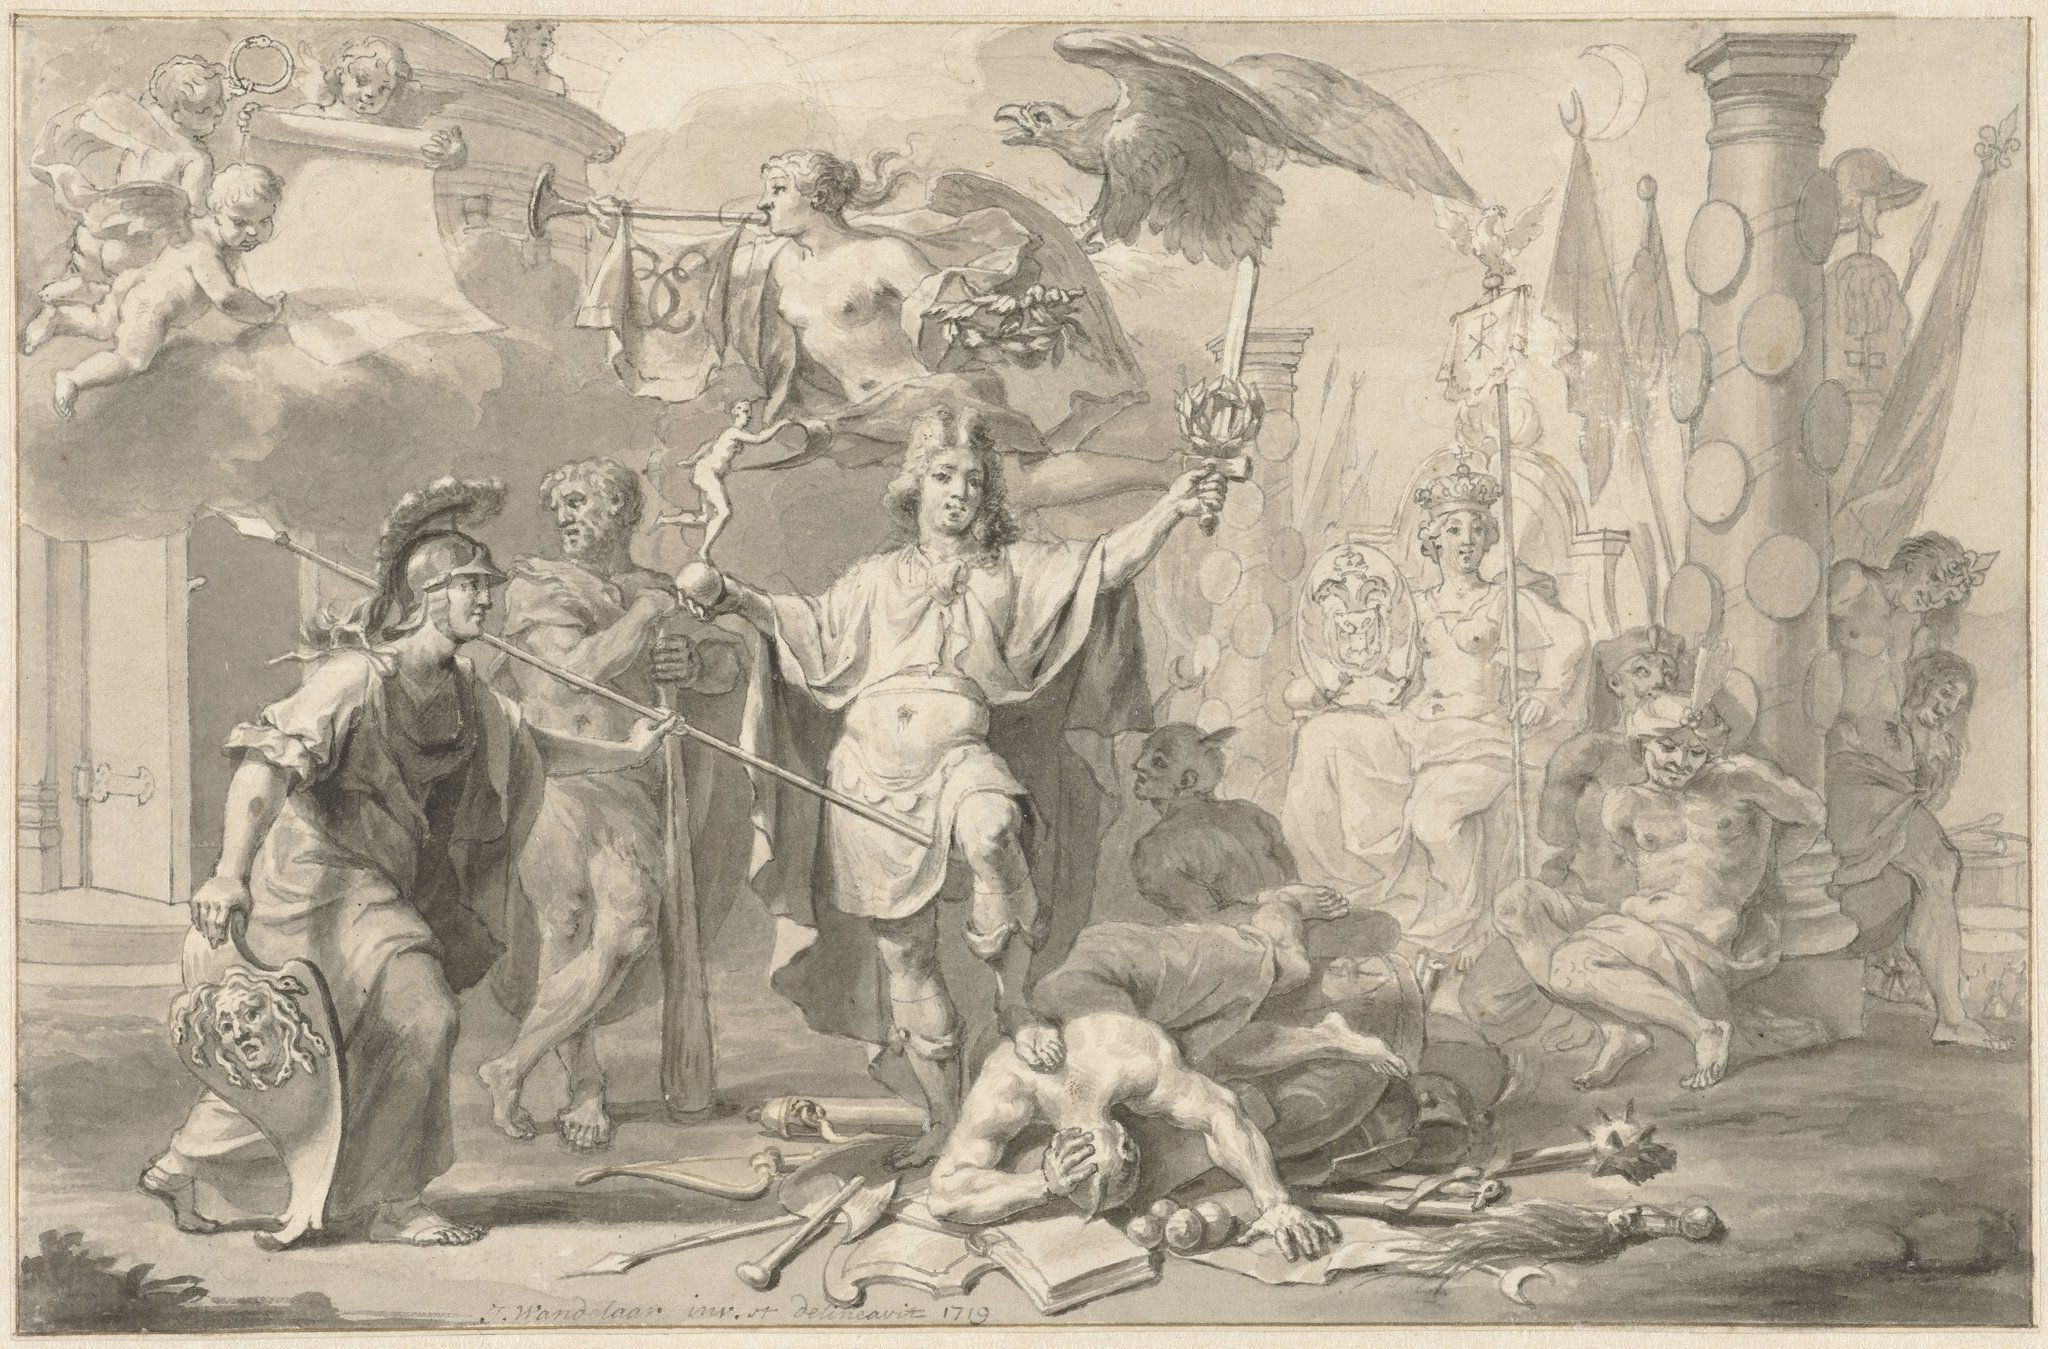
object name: design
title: Allegorie op de overwinningen van prins Eugenius van Savoye, 1719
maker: jan wandelaar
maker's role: draughtsman, print maker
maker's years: 1690-1759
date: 1719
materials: paper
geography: northern netherlands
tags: asiatic races and peoples, (story of) hercules (heracles), (story of) minerva (pallas, athena), symbolic triumphs of individual persons, fame; 'fama', 'fama buona', 'fama chiara' (ripa), the defeated (after the battle)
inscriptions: inscription: ‘J.Wandelaar inv. et delineavit 1719’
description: Triomf van prins Eugenius van Savoye, 1719. Allegorie op de vele militaire overwinningen van de prins. Centraal de prins staande met opgeheven zwaard en de voet op een overwonnen vijand. Links Hercules en Minerva, in de lucht de Faam en de Duitse adelaar, rechts gevangen Turken geketend bij een triomfzaal. Ontwerp voor een prent.